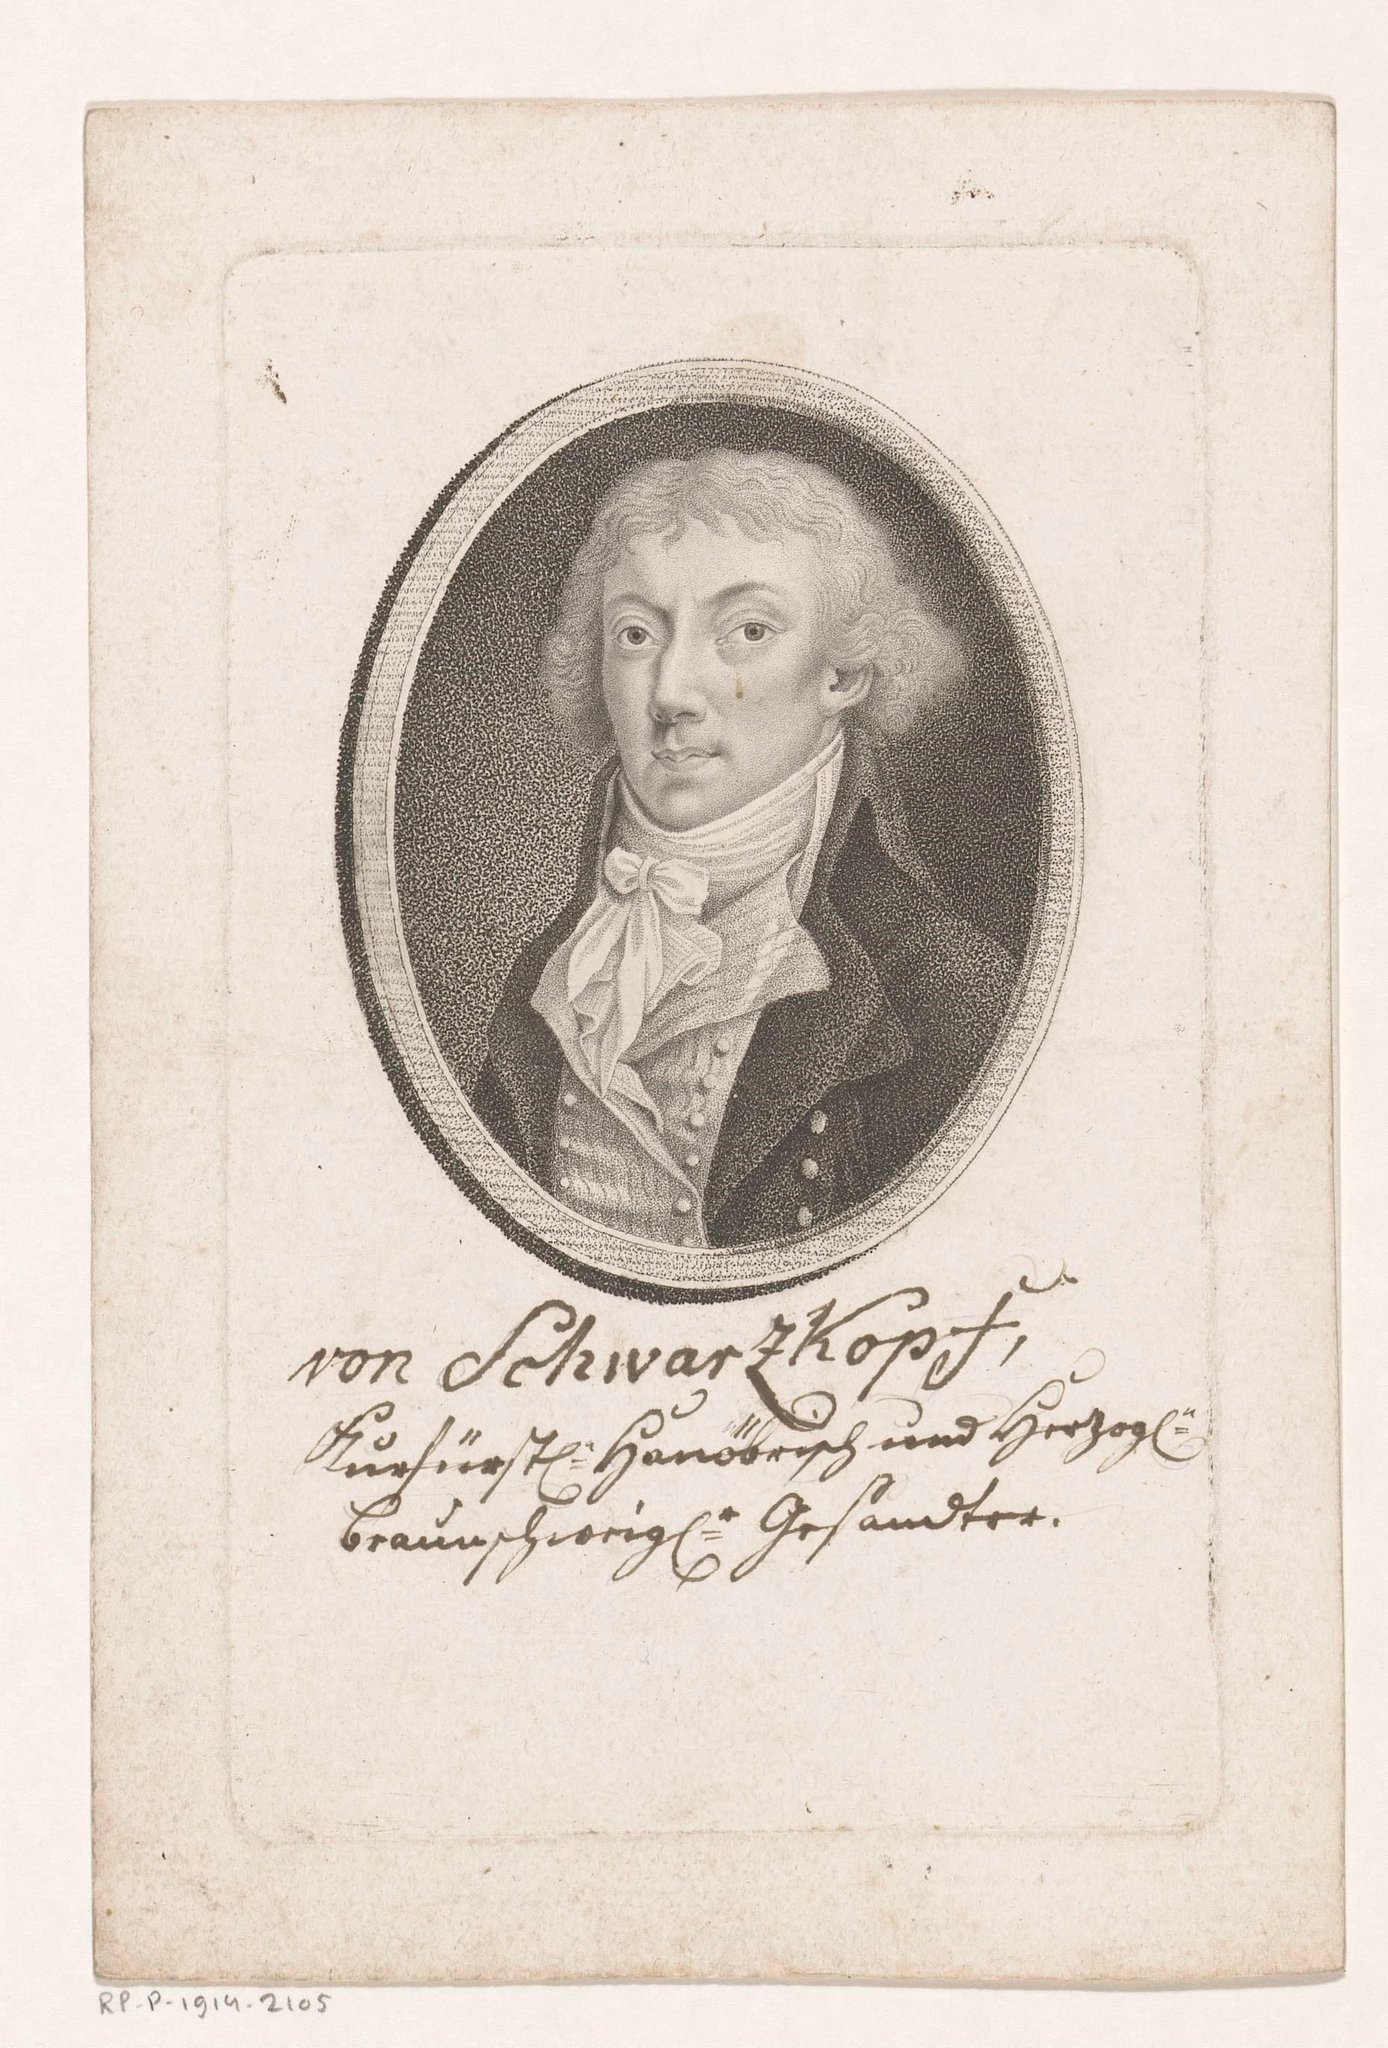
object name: print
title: Portret van Joachim Schwarzkopf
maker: johann carl bock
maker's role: print maker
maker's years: 1757-1843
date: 1805-1843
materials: paper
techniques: etching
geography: nuremberg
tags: historical persons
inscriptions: collector's mark: Lugt 2228, inscription: ‘Von Schwarzkopf / kurfürstl. [...] Gesandter’